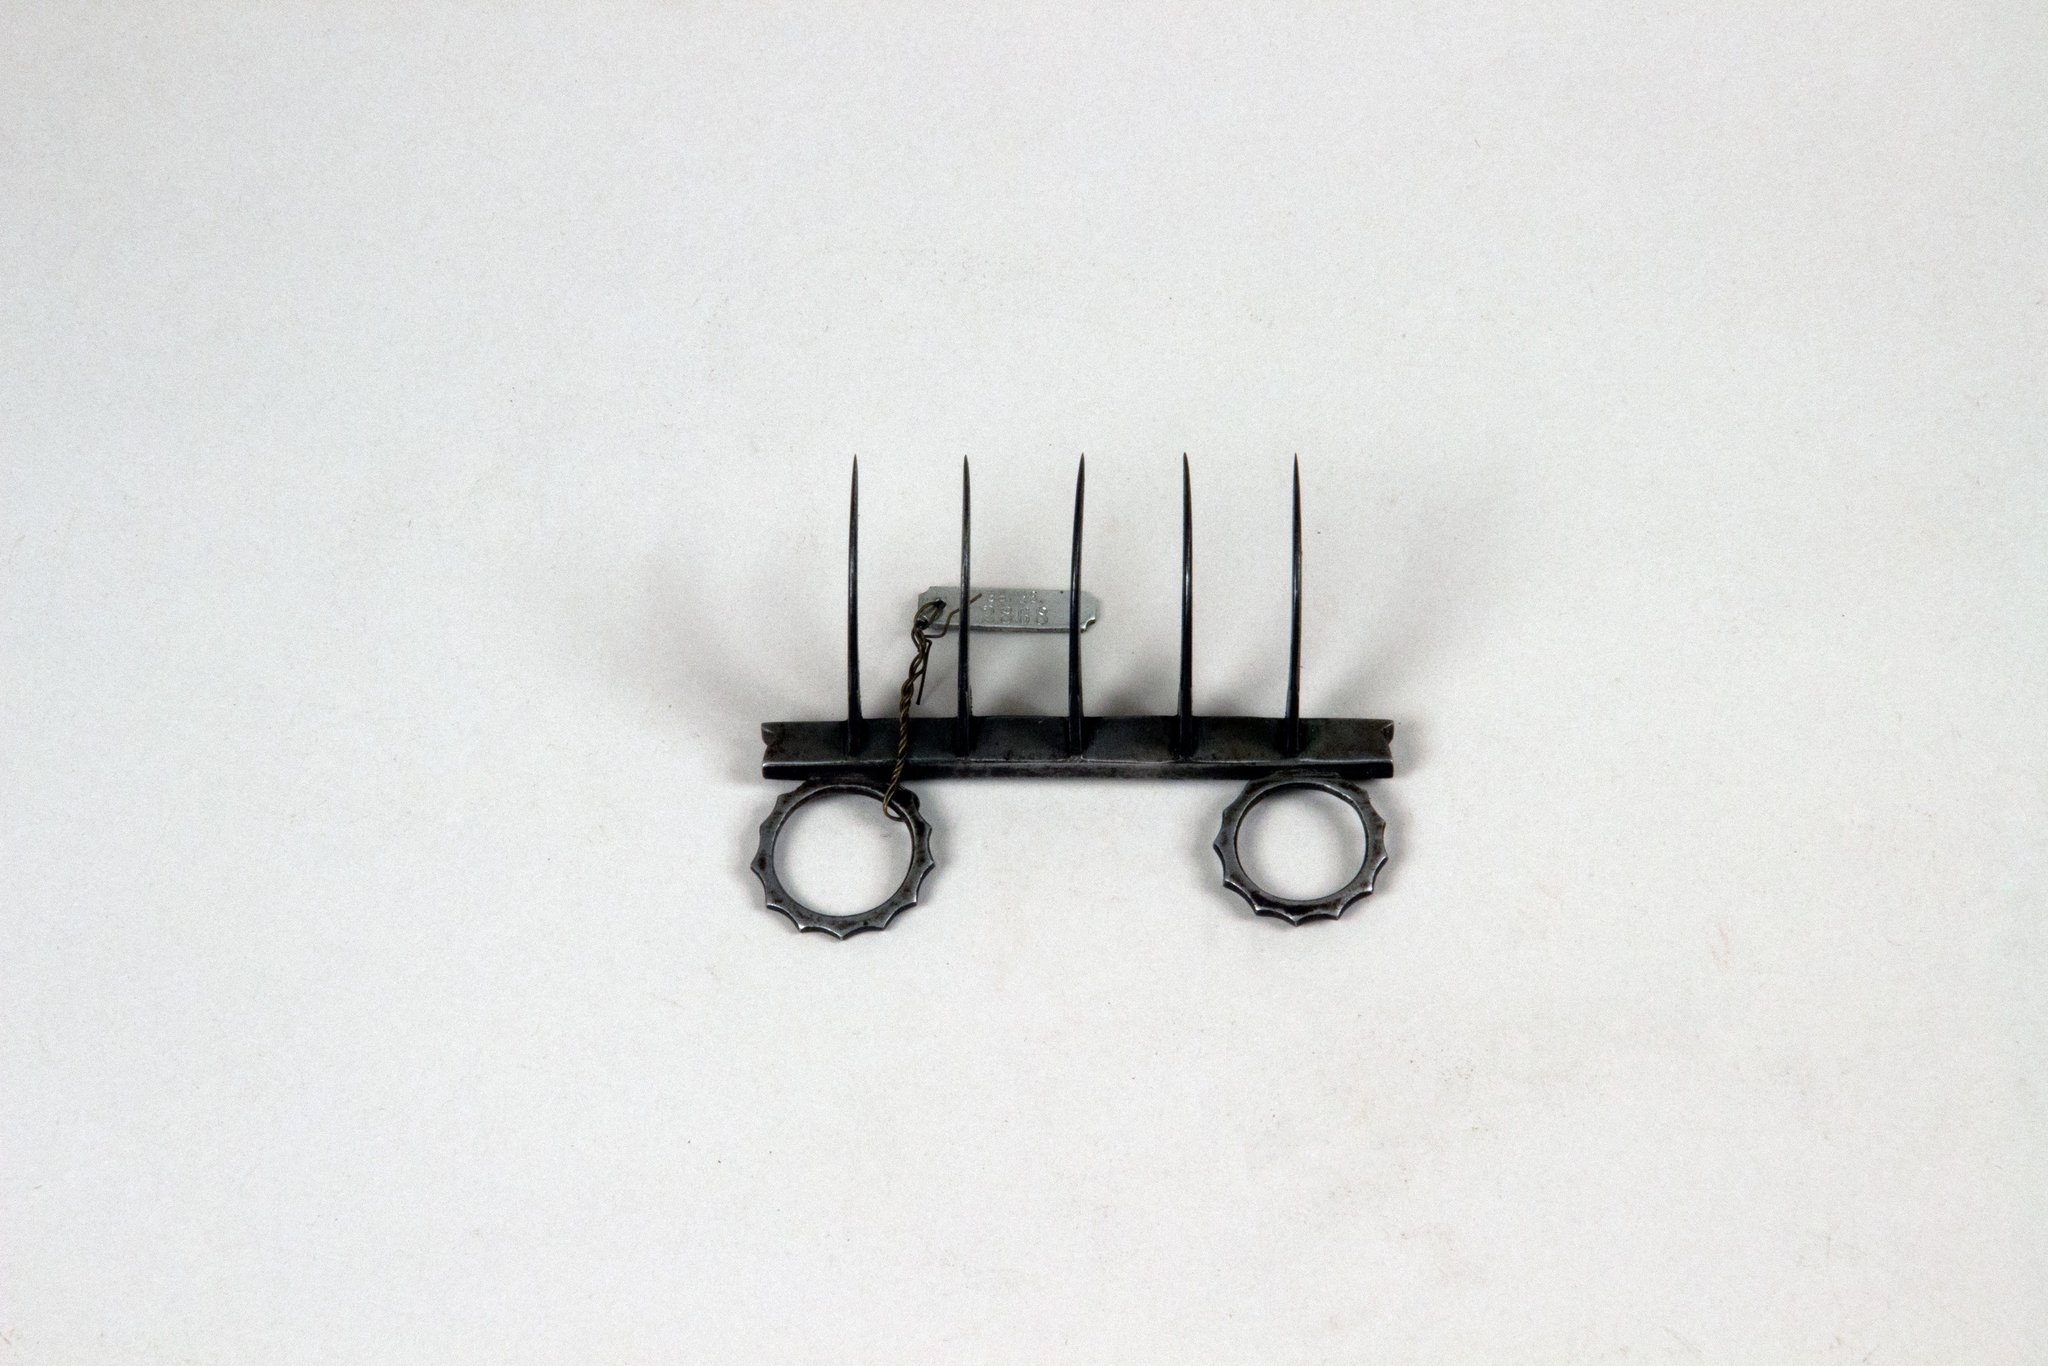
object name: tiger's claw bagh nakh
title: Tiger's Claw (Bagh Nakh)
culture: indian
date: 1701-1900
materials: steel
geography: india